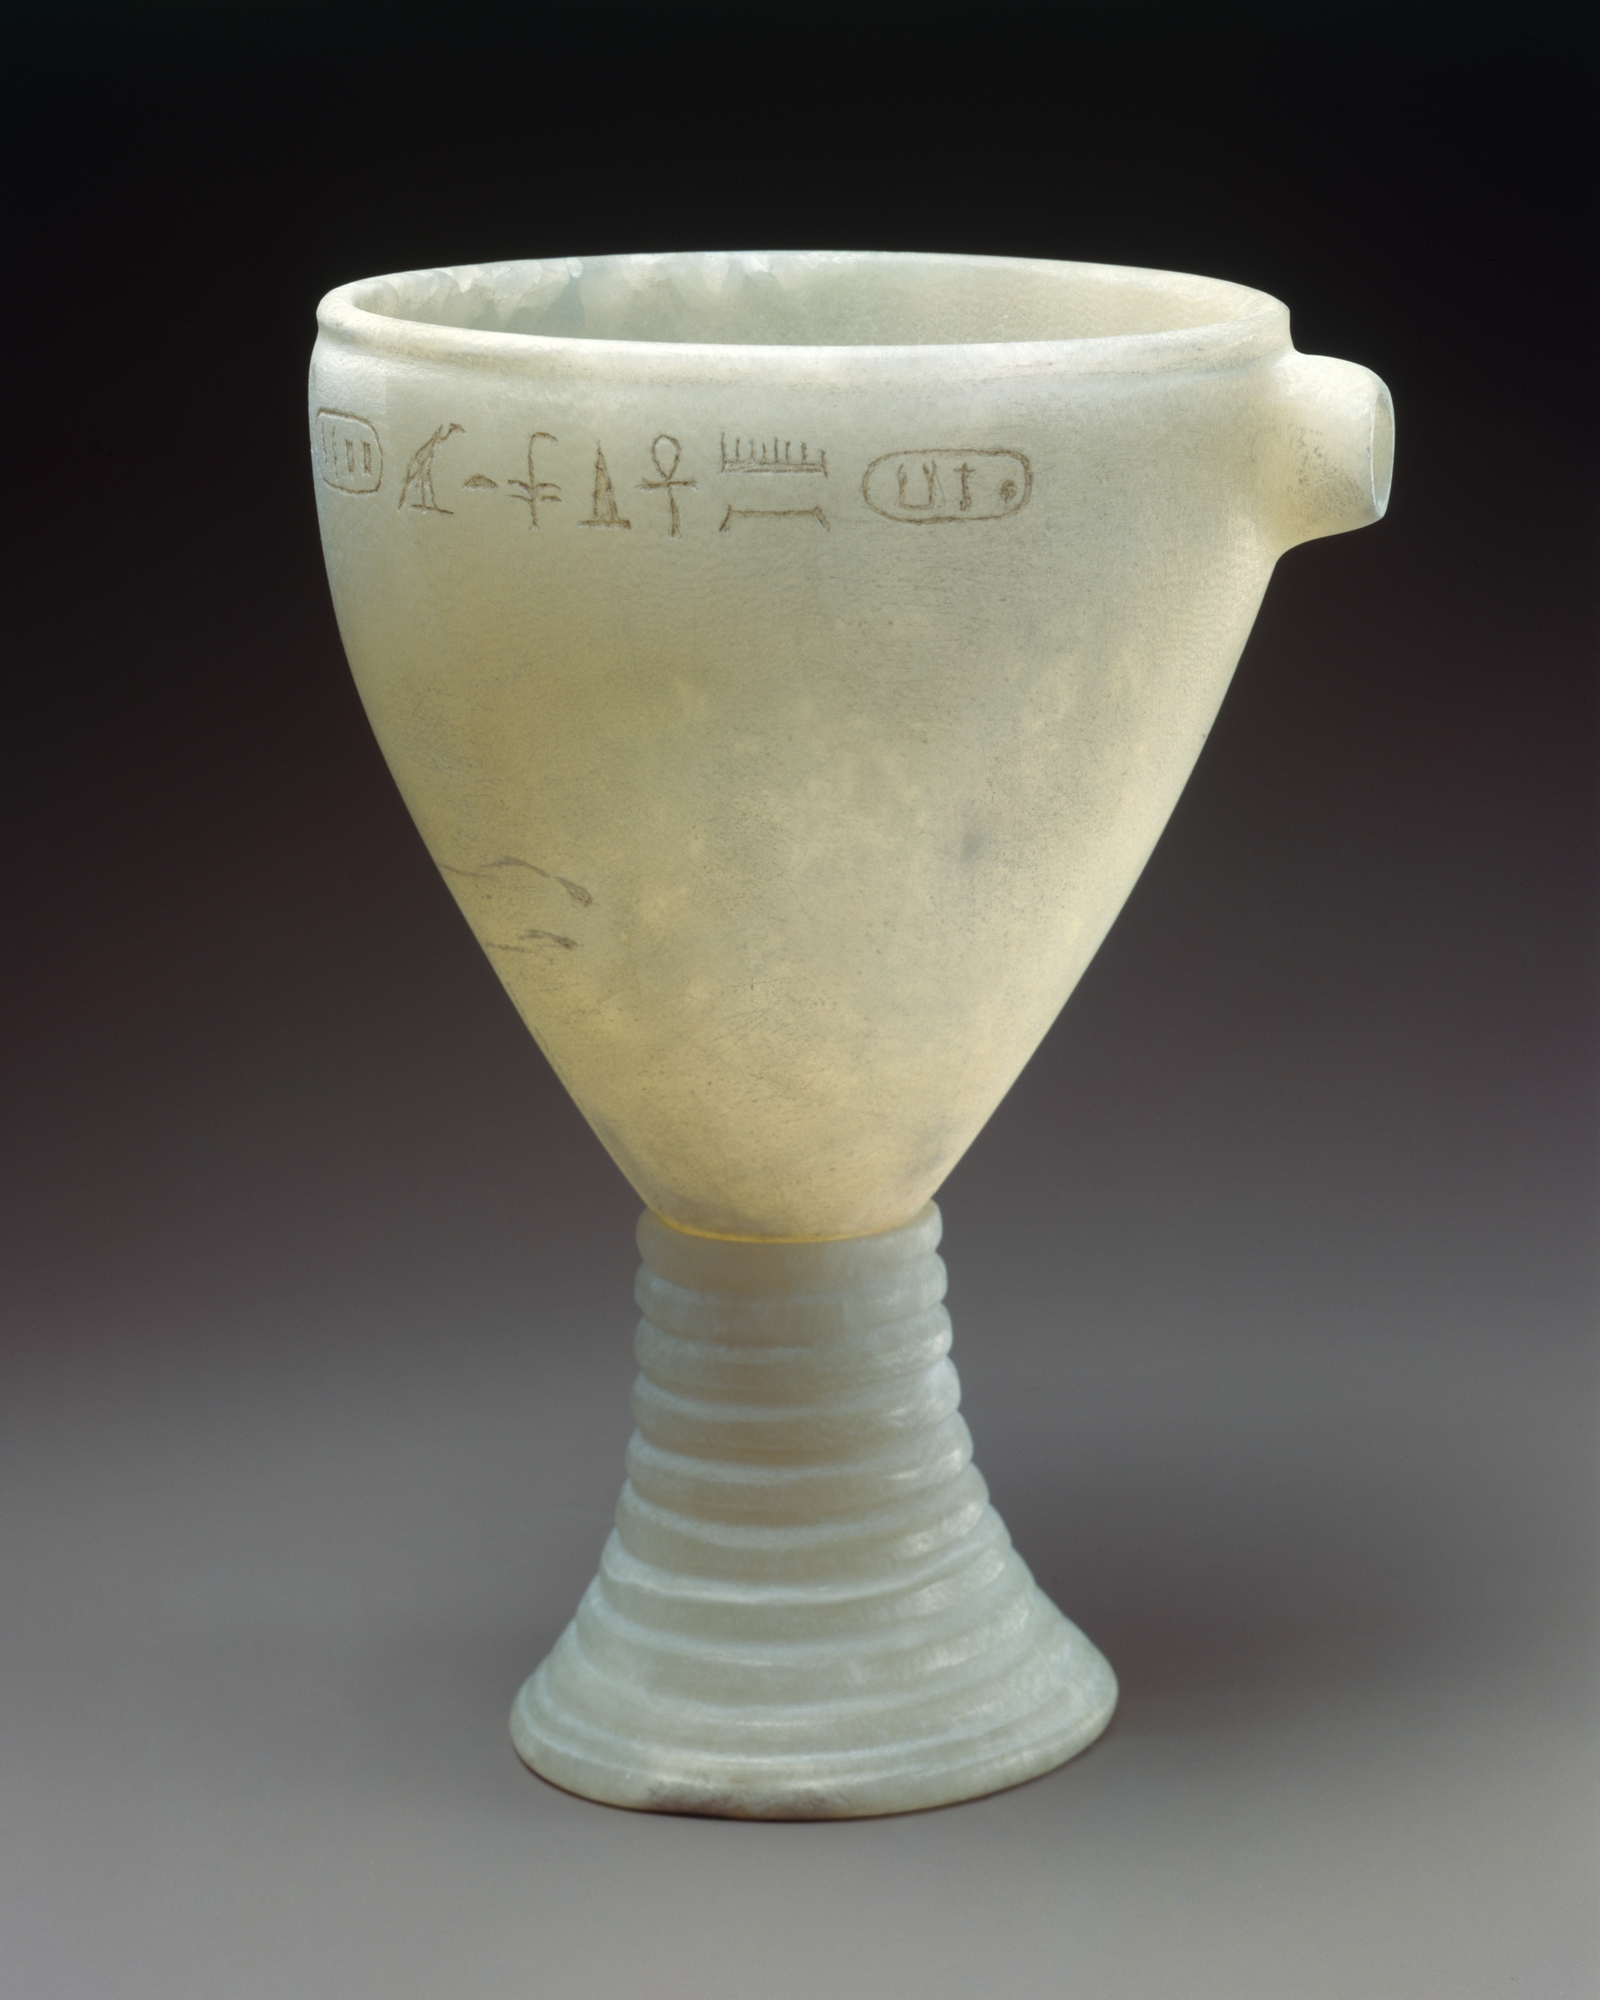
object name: model, brewer, vat, ankhenes pepi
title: Brewer's Vat of Queen Mother Ankhenes-Pepi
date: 2246-2152 BCE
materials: stone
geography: memphite region